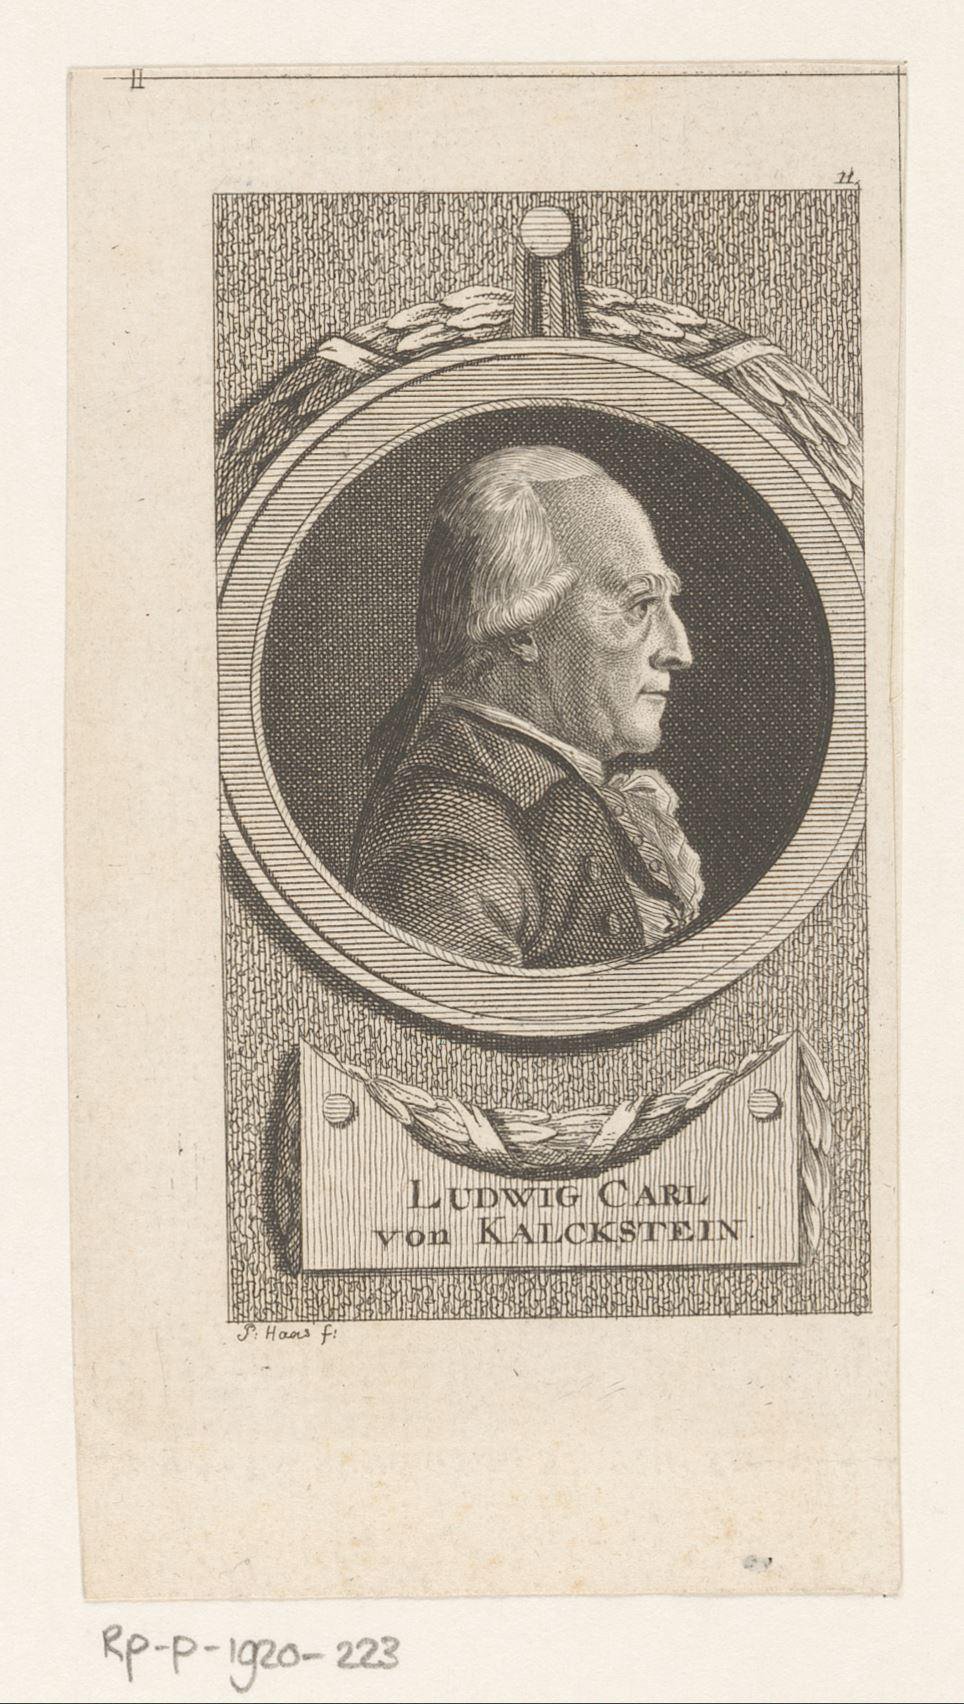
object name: print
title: Portret van Ludwig Karl von Kalckstein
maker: peter haas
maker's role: print maker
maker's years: 1754-1804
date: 1764-1800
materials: paper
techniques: engraving, etching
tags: ornament ~ medallion, commander-in-chief, general, marshal, historical persons, ornament ~ festoon, garland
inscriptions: collector's mark: Lugt 2228